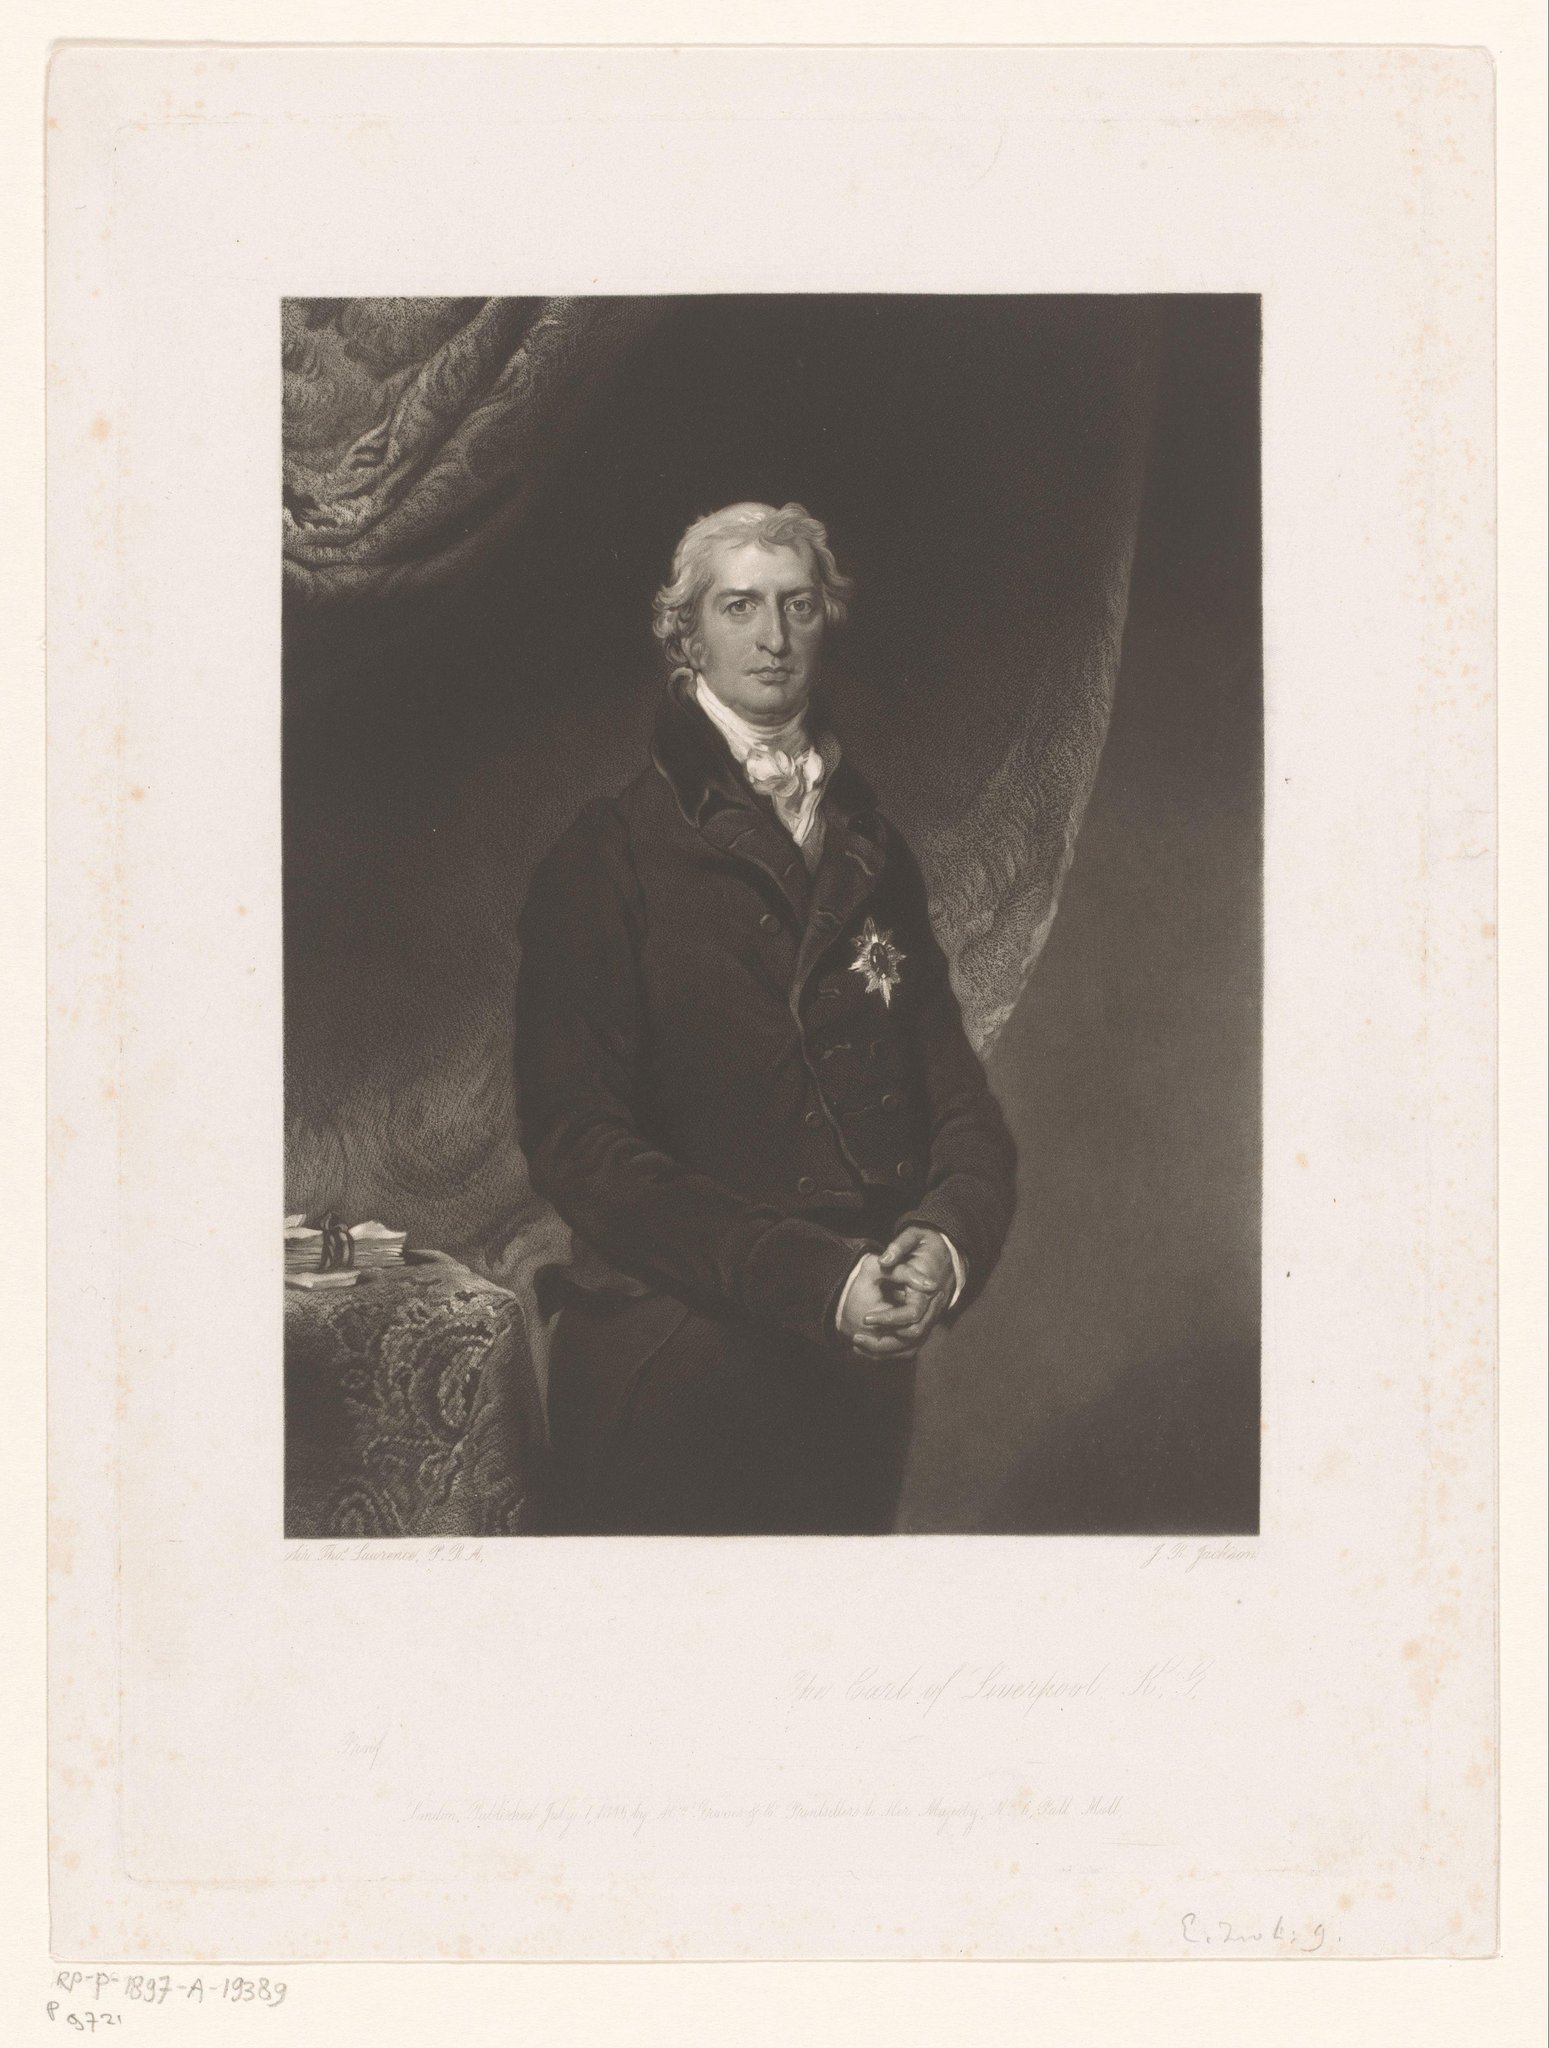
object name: print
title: Portret van Robert Banks Jenkinson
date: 1845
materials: paper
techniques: mezzotint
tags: politician, robert jenkinson (2e graaf van liverpool), historical persons, politician, e.g. party leader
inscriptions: collector's mark: Lugt 2228